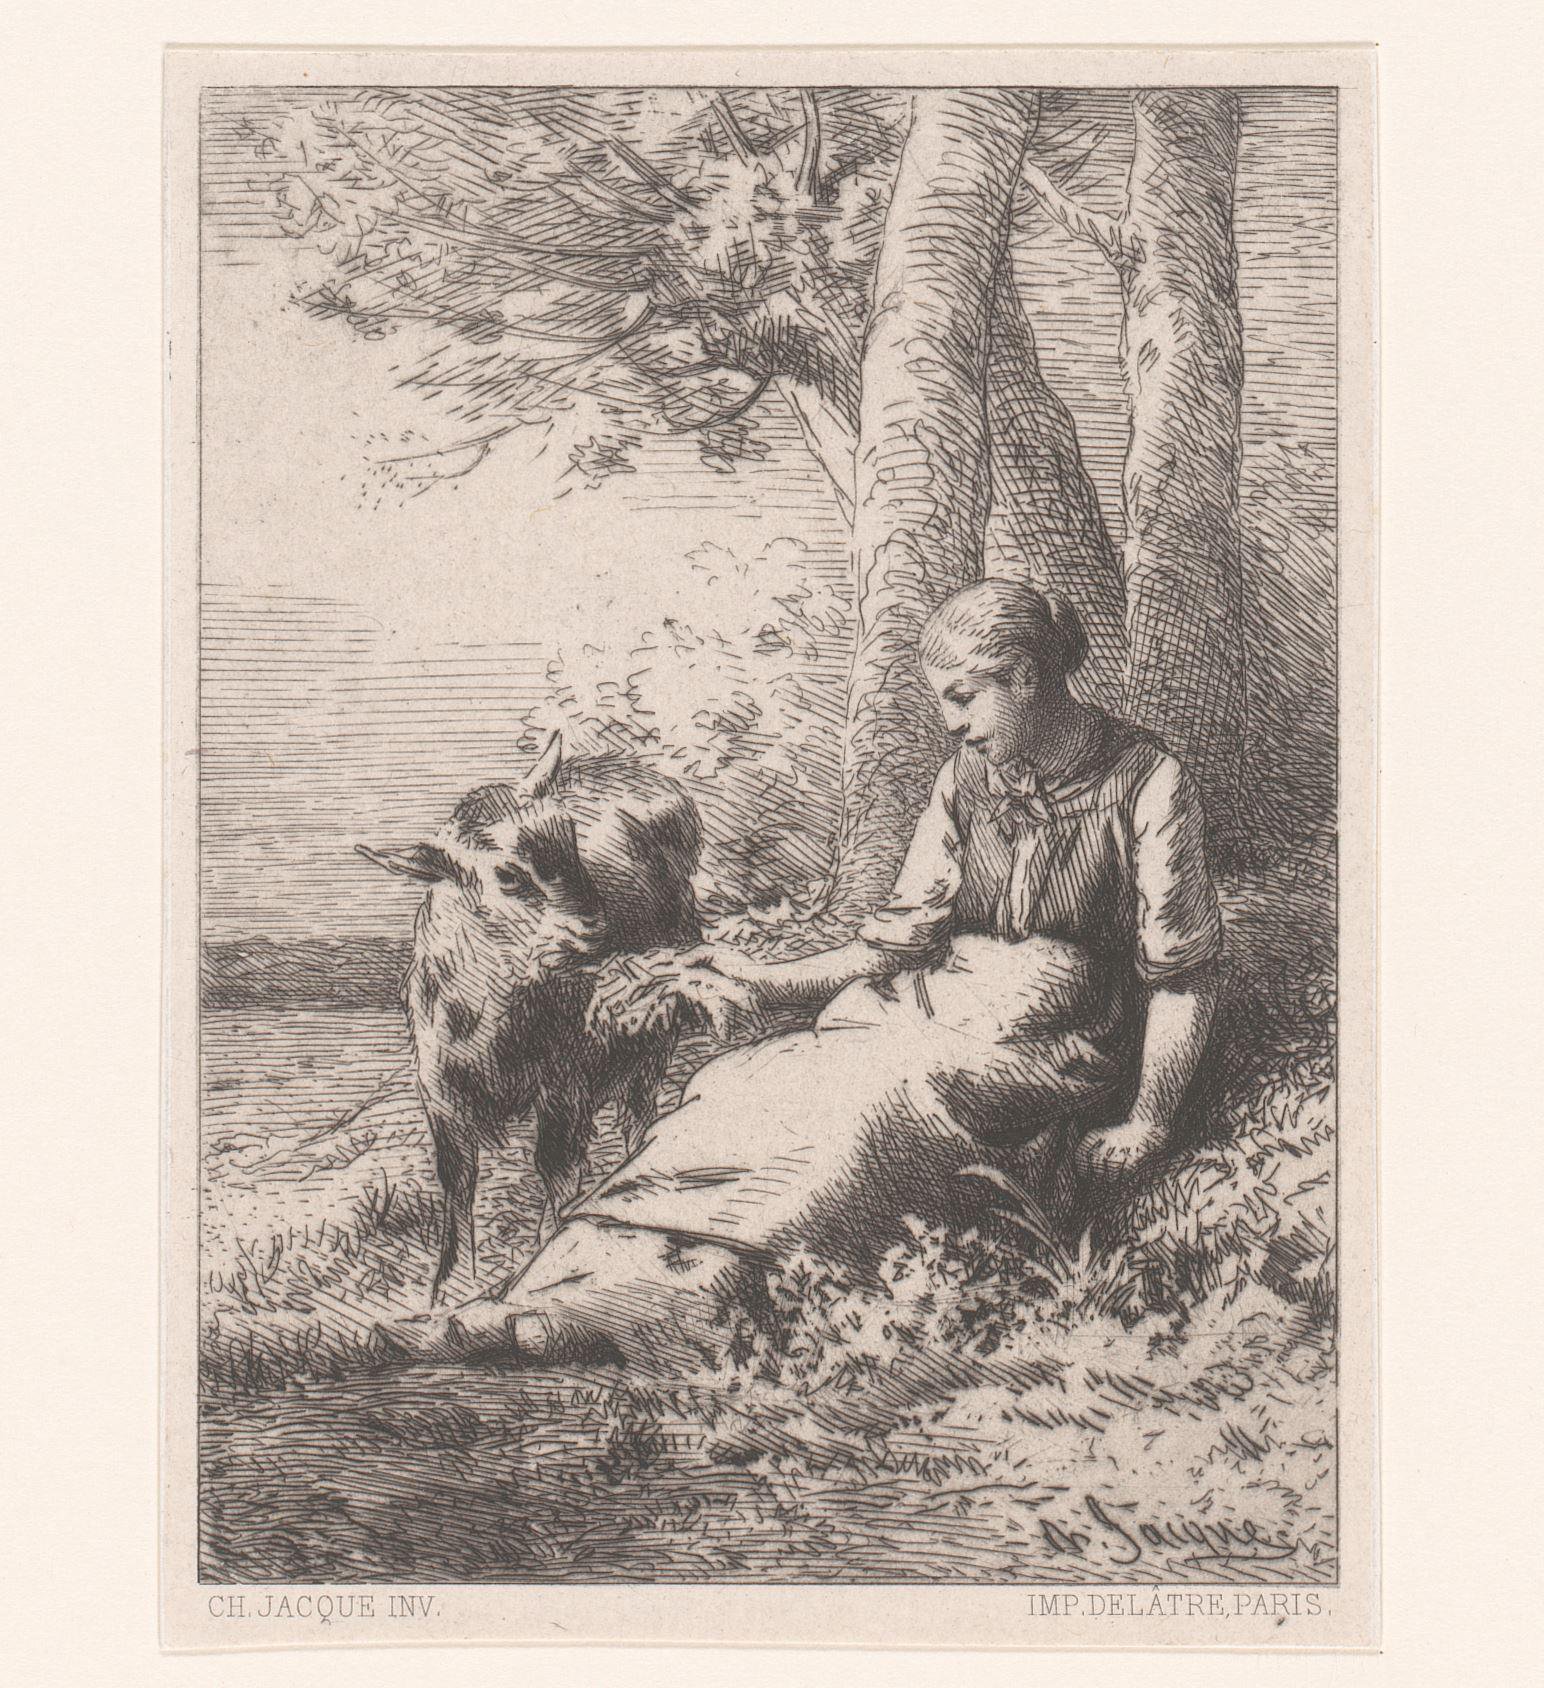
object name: print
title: Meisje met kalf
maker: charles emile jacque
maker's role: draughtsman, painter, print maker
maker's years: 1813-1894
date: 1823-1894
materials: paper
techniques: drypoint, engraving, etching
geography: france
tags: adolescent, young woman, maiden, calf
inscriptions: collector's mark: Lugt 964